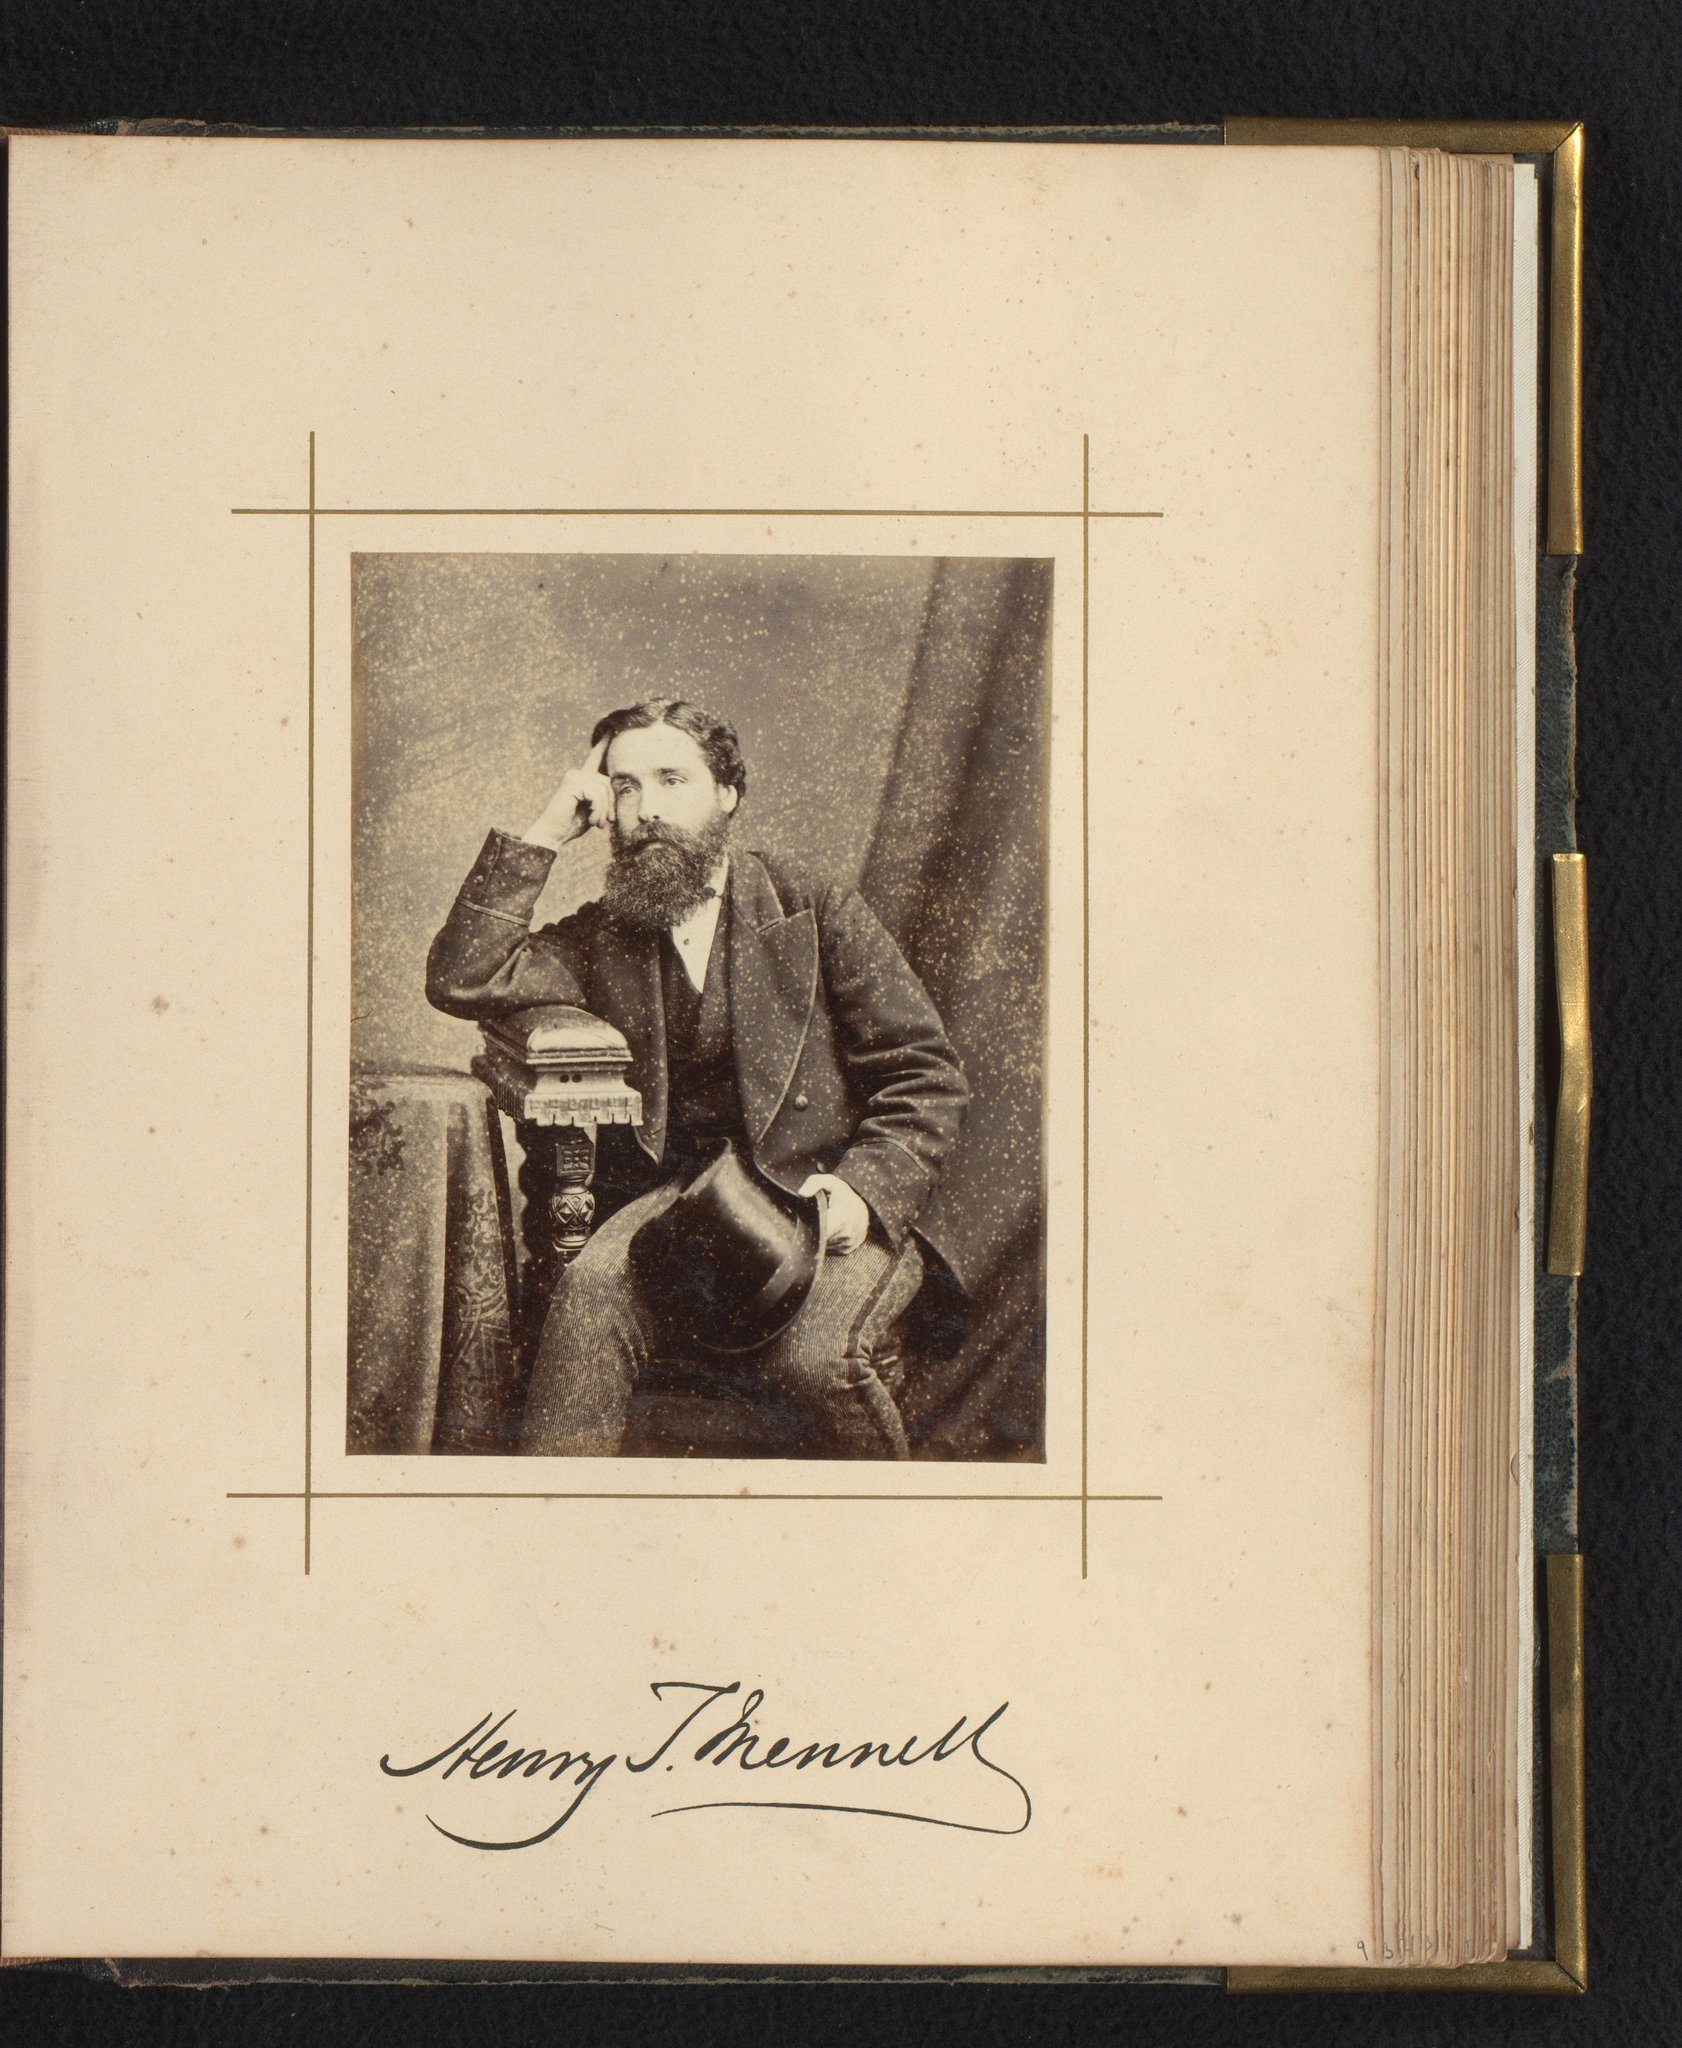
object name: photograph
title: Portret van een man, mogelijk Henry J. Mennell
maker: Anonymous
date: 1866-1871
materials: photographic support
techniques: albumen print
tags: historical persons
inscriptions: name: ‘[Henry J. Mennell]’